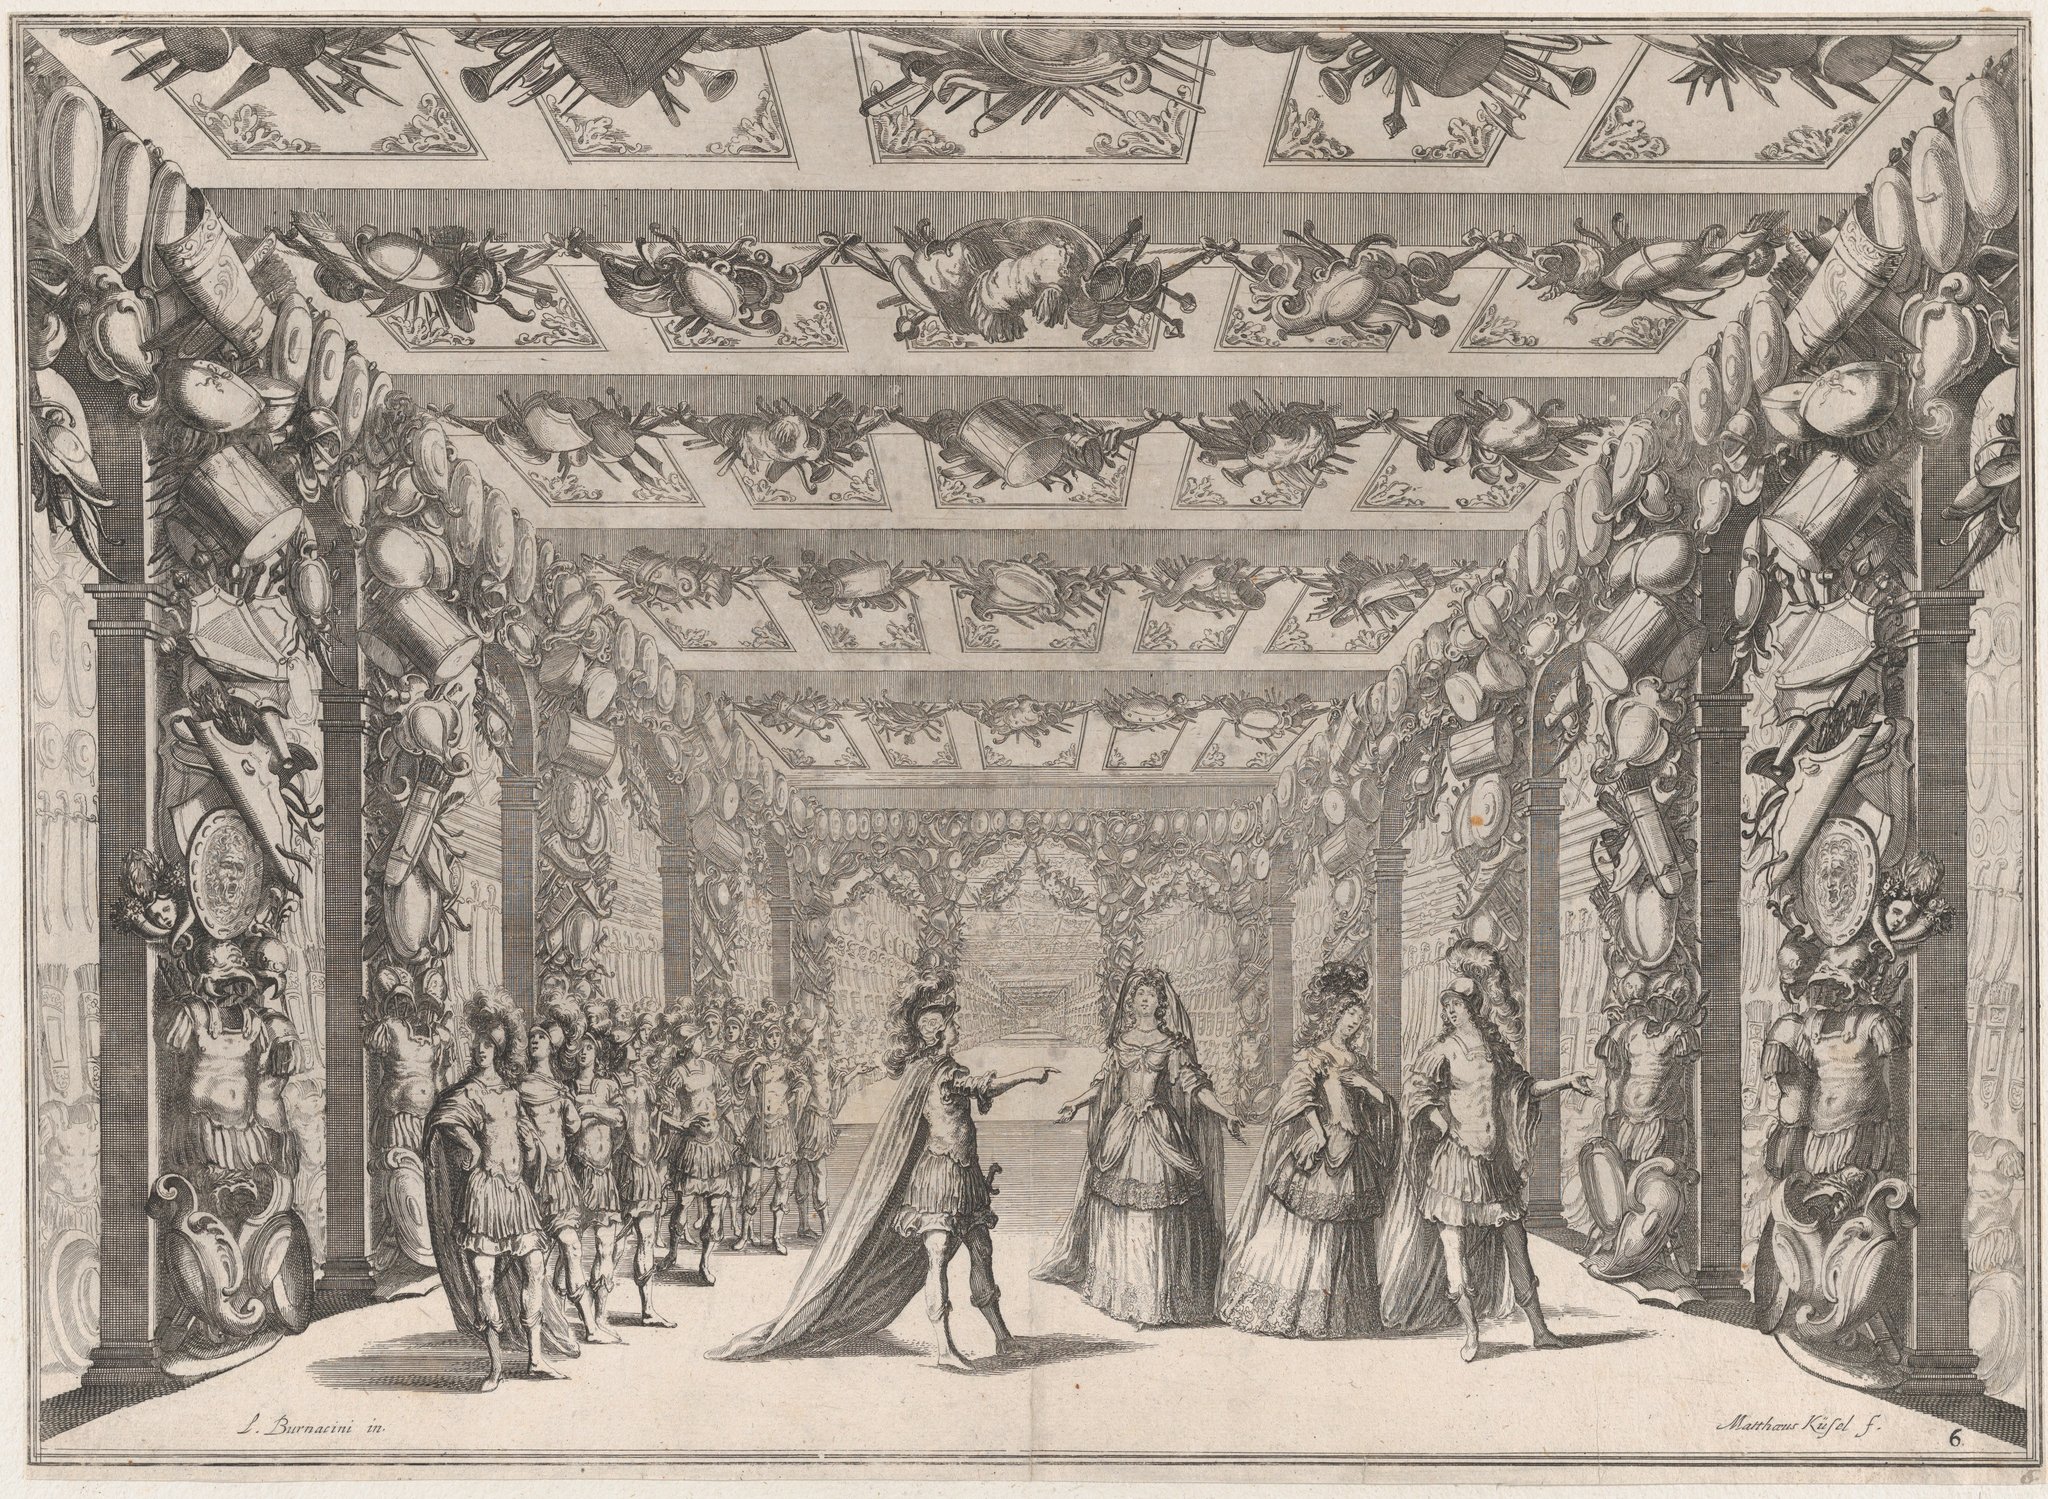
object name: print, fete, ornament architecture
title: The Arsenal; two soldiers conversing with two women on the right as a group of soldiers look on from the left; set design from 'Il Fuoco Eterno'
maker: mathäus küsel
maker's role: artist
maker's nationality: german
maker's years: 1621-1682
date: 1674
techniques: etching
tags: soldiers,armor,shields,weapons,women